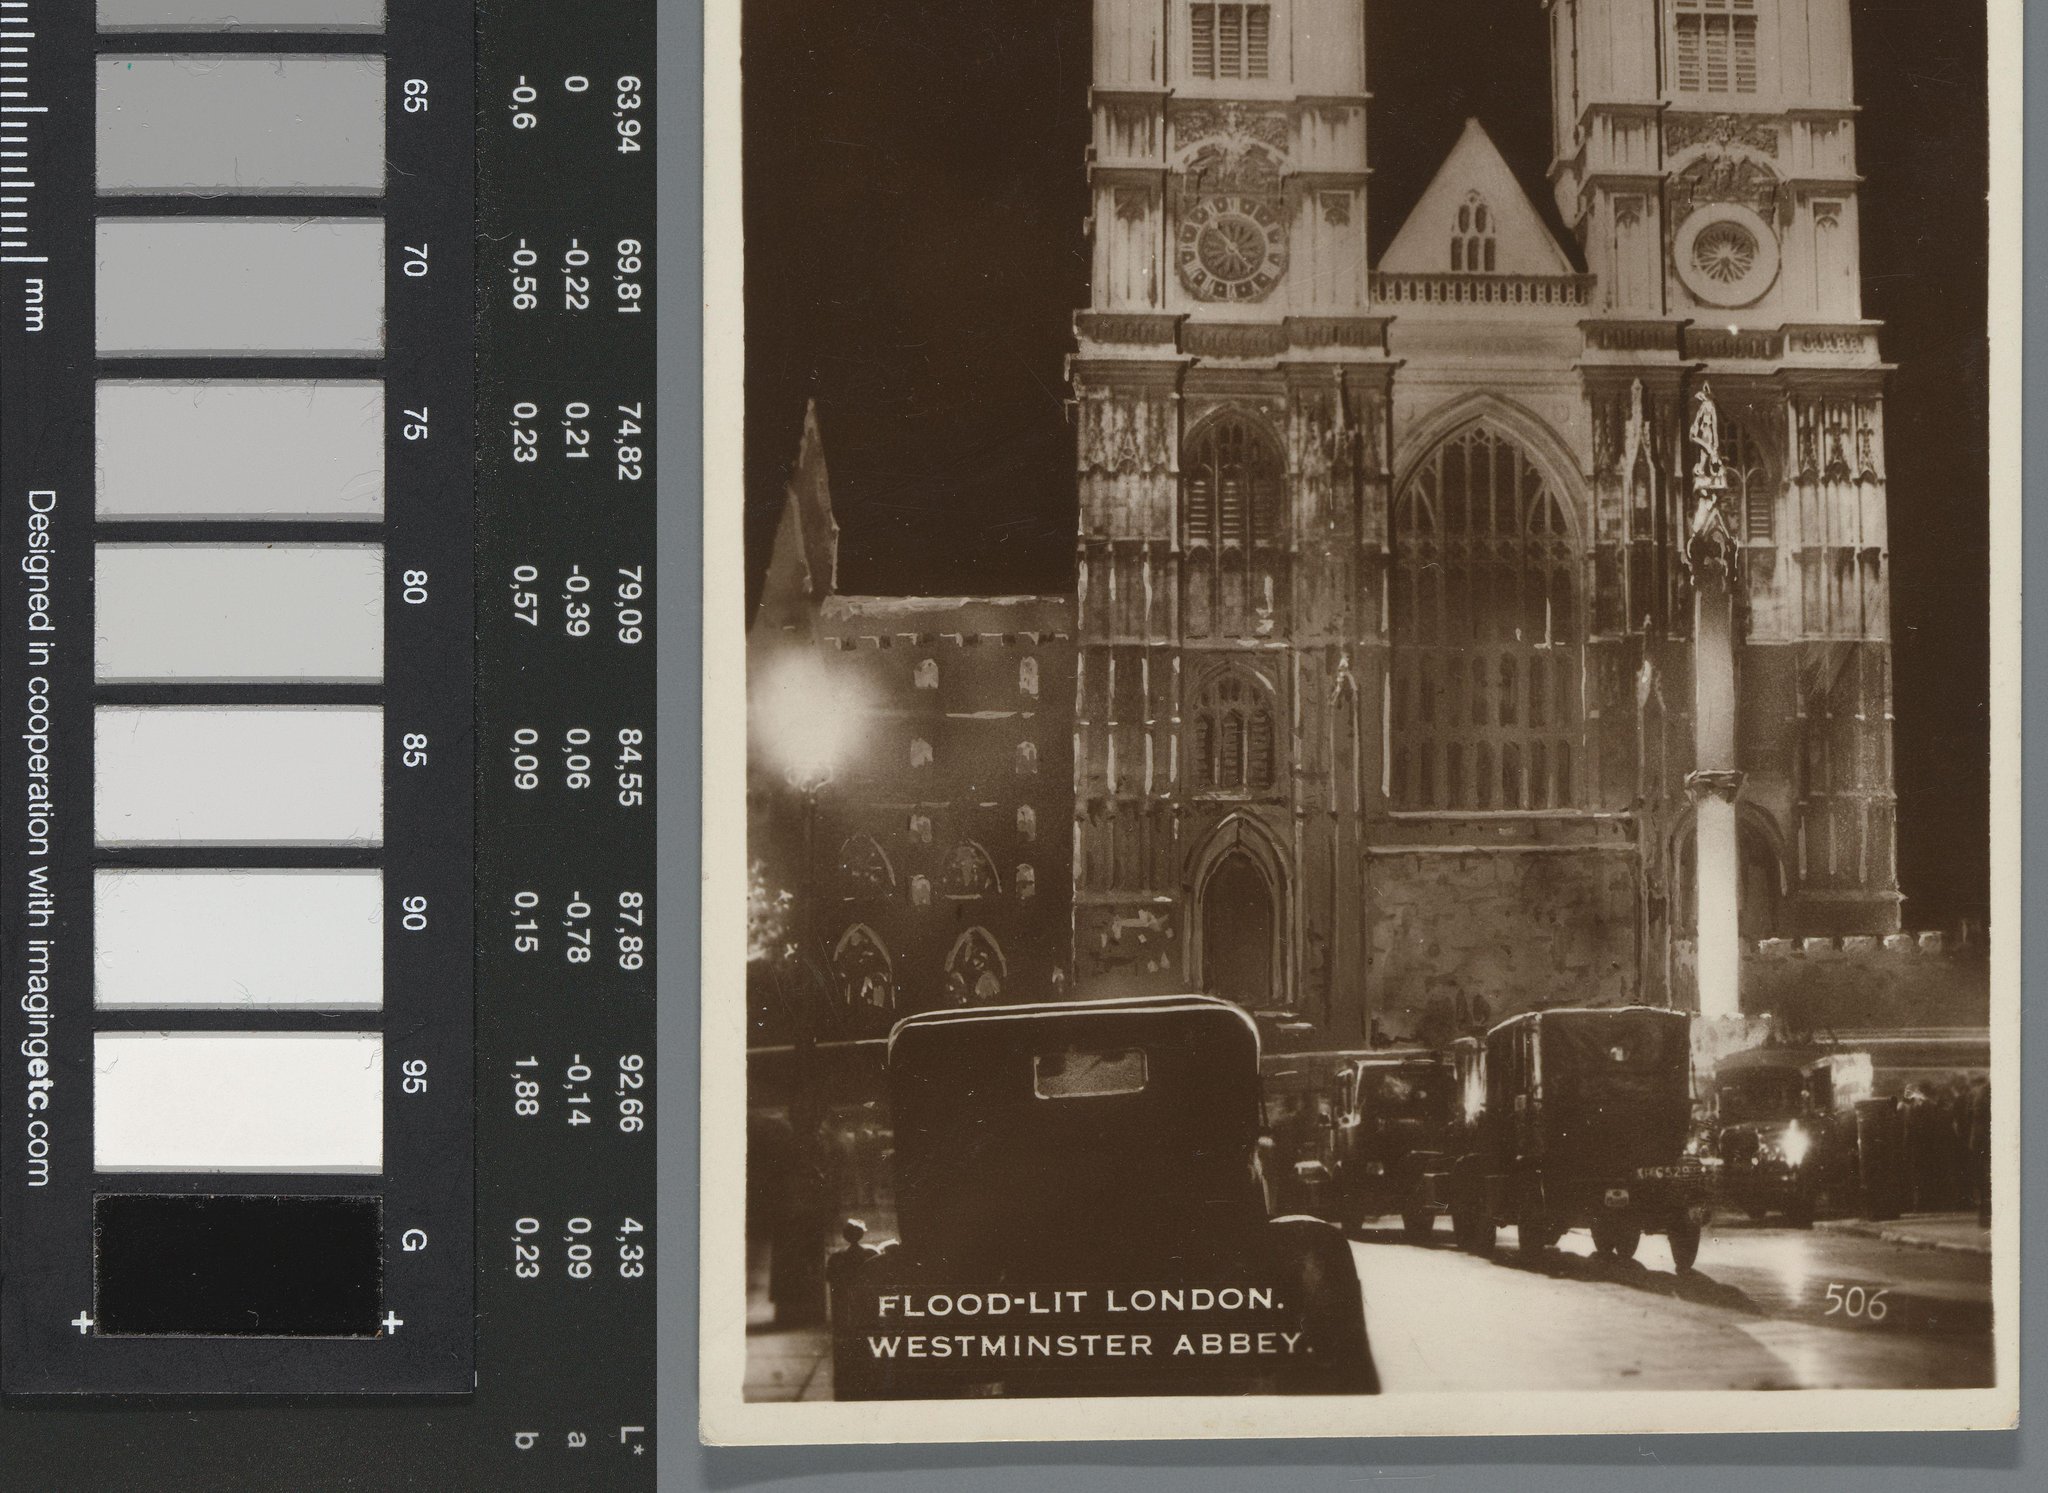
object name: postcard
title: London, Westminster Abbey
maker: Anonymous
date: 1920-1950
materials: photographic support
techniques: gelatin silver print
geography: london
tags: westminster abbey